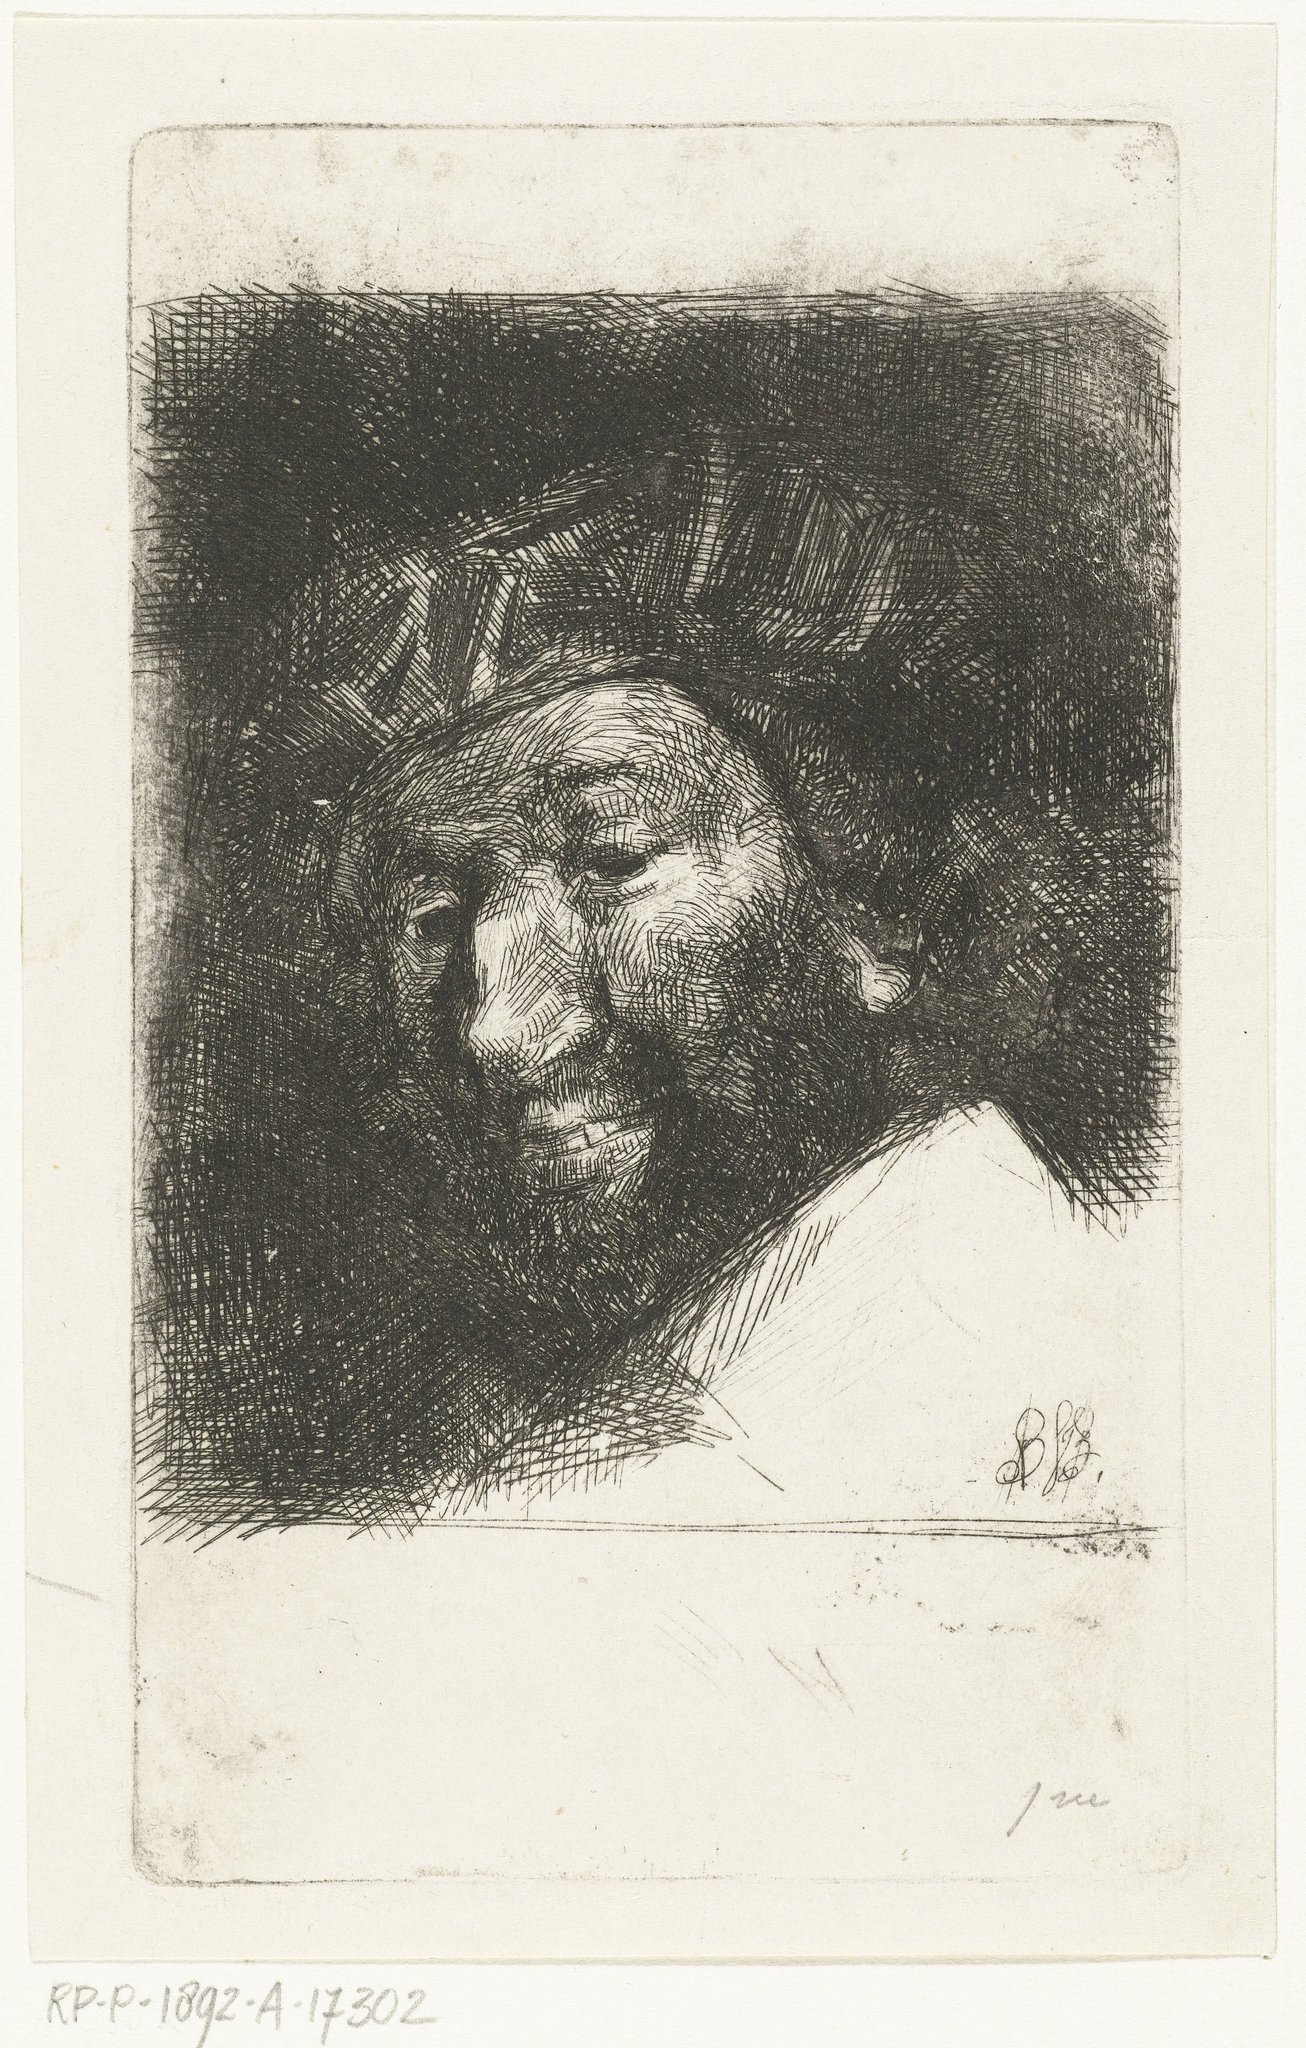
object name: print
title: Portret van lachende man met baard en muts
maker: bernardus johannes blommers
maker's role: draughtsman, print maker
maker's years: 1845-1914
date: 1855-1892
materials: paper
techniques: drypoint, etching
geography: netherlands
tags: laughing, portrait, self-portrait of artist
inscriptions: collector's mark: Lugt 2228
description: Portret of buste van lachende man met baard en schildersmuts.